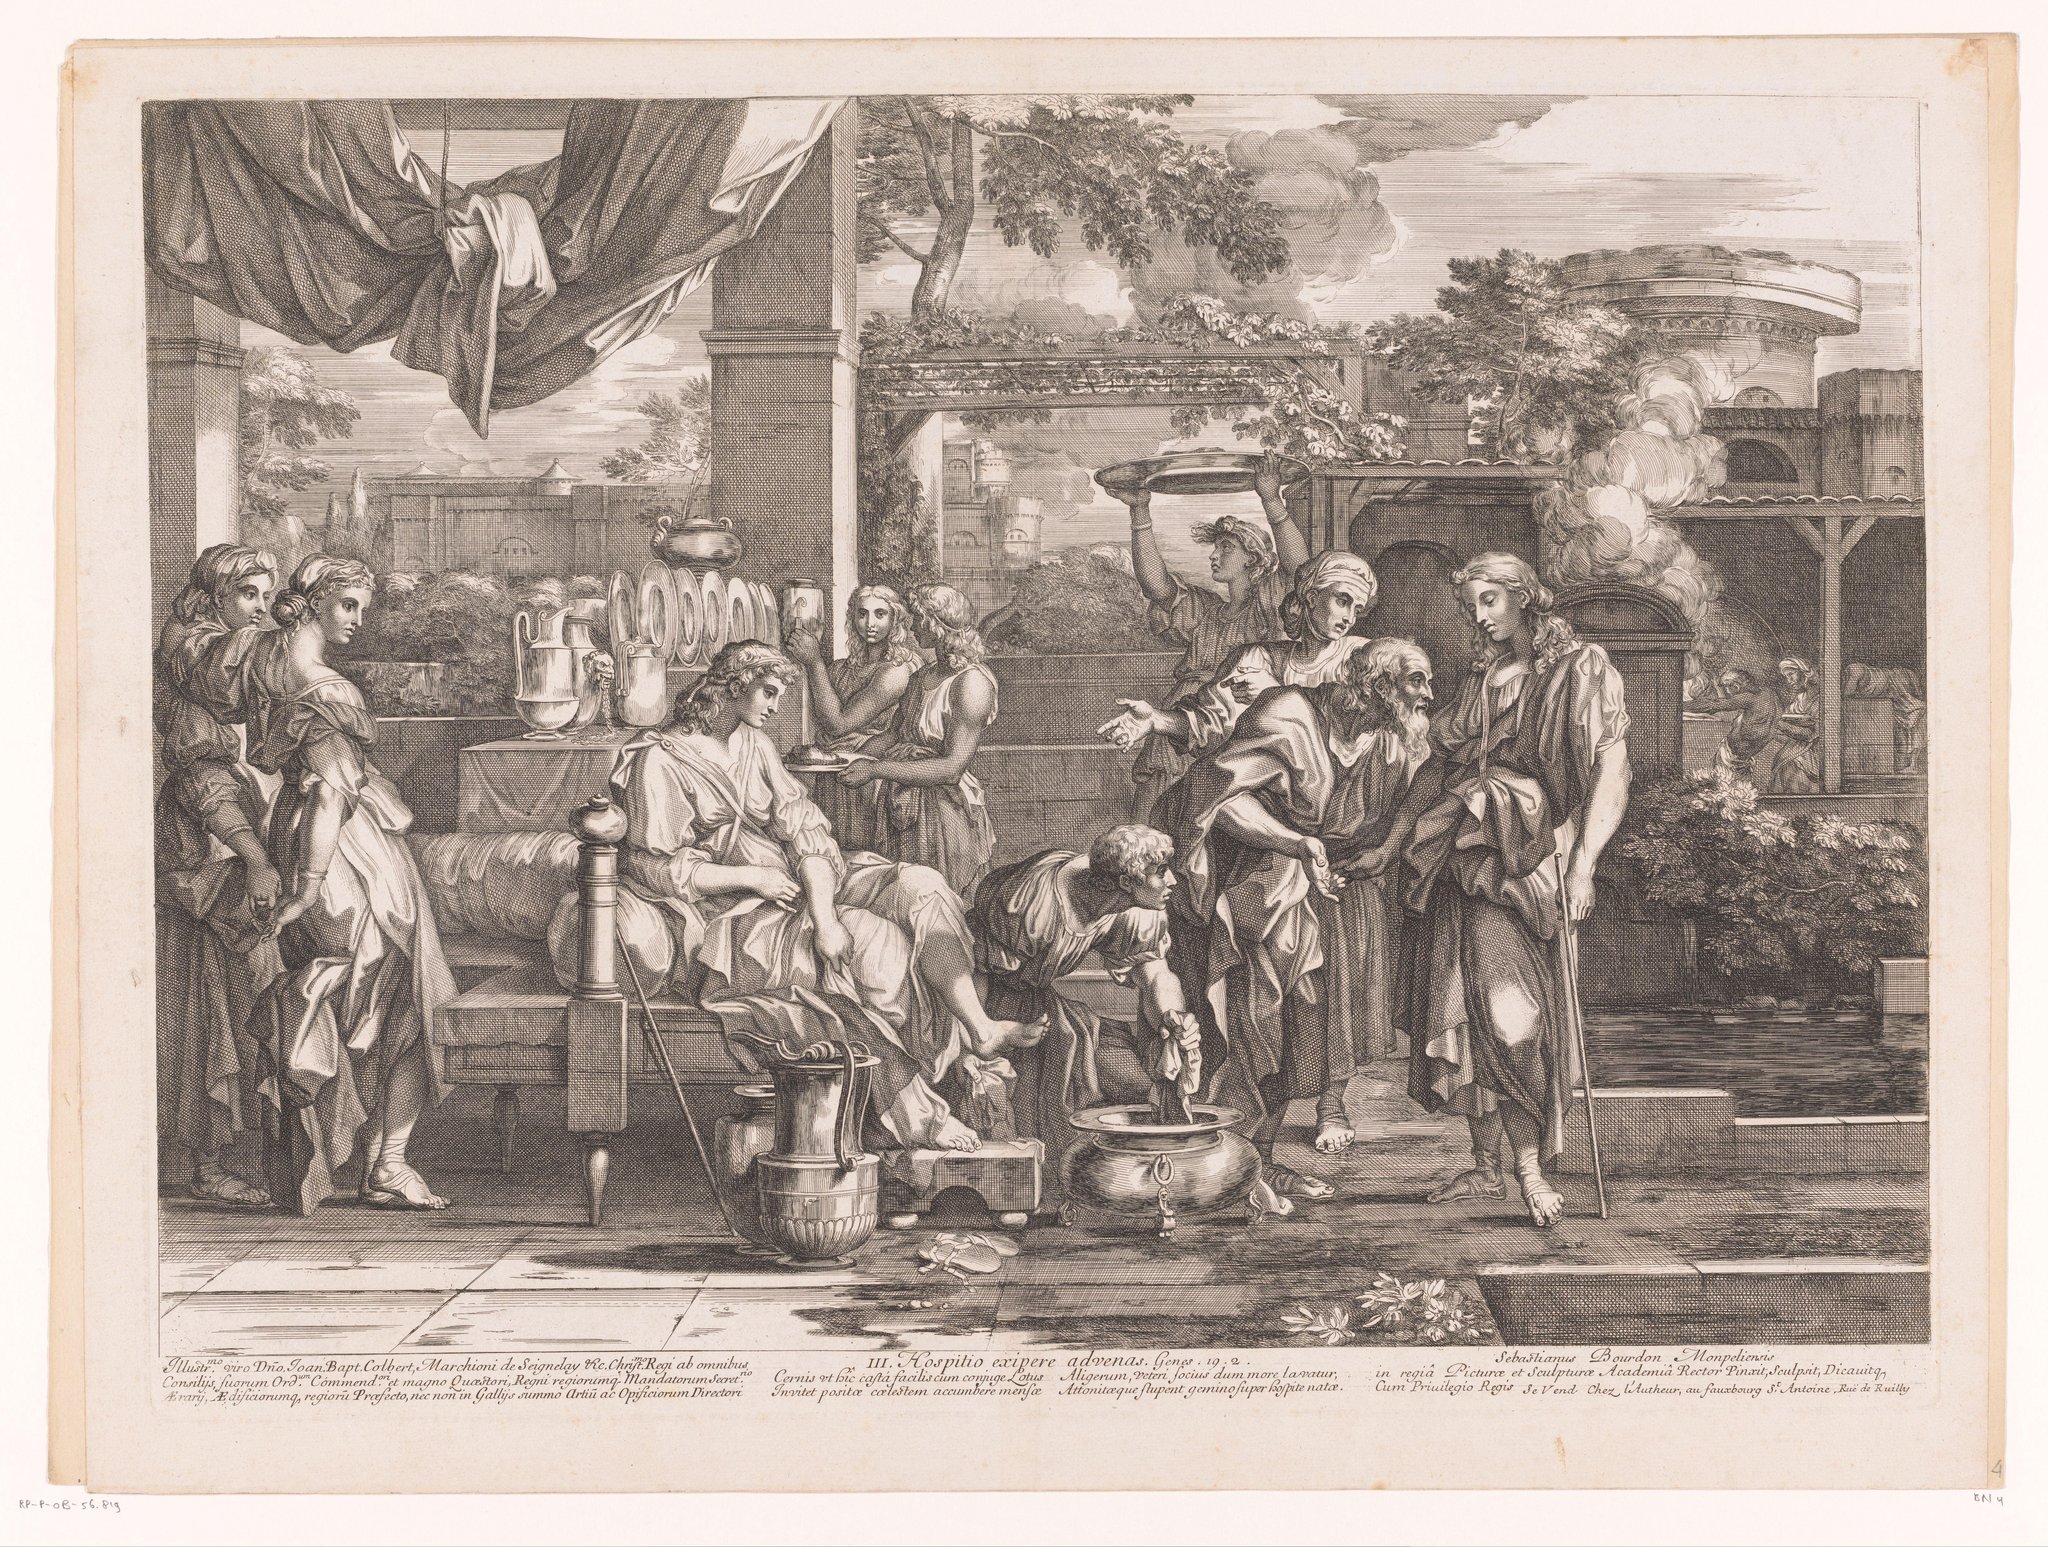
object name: print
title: Herbergen van vreemdelingen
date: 1626-1671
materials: paper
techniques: engraving, etching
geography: france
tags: lot entertaining the angels, sheltering strangers, 'hospes colligitur' ~ one of the (seven) acts of mercy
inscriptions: collector's mark: Lugt 240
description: Maakt deel uit van een zevendelige serie met de zeven werken van barmhartigheid. De hele serie is opgedragen aan Colbert.